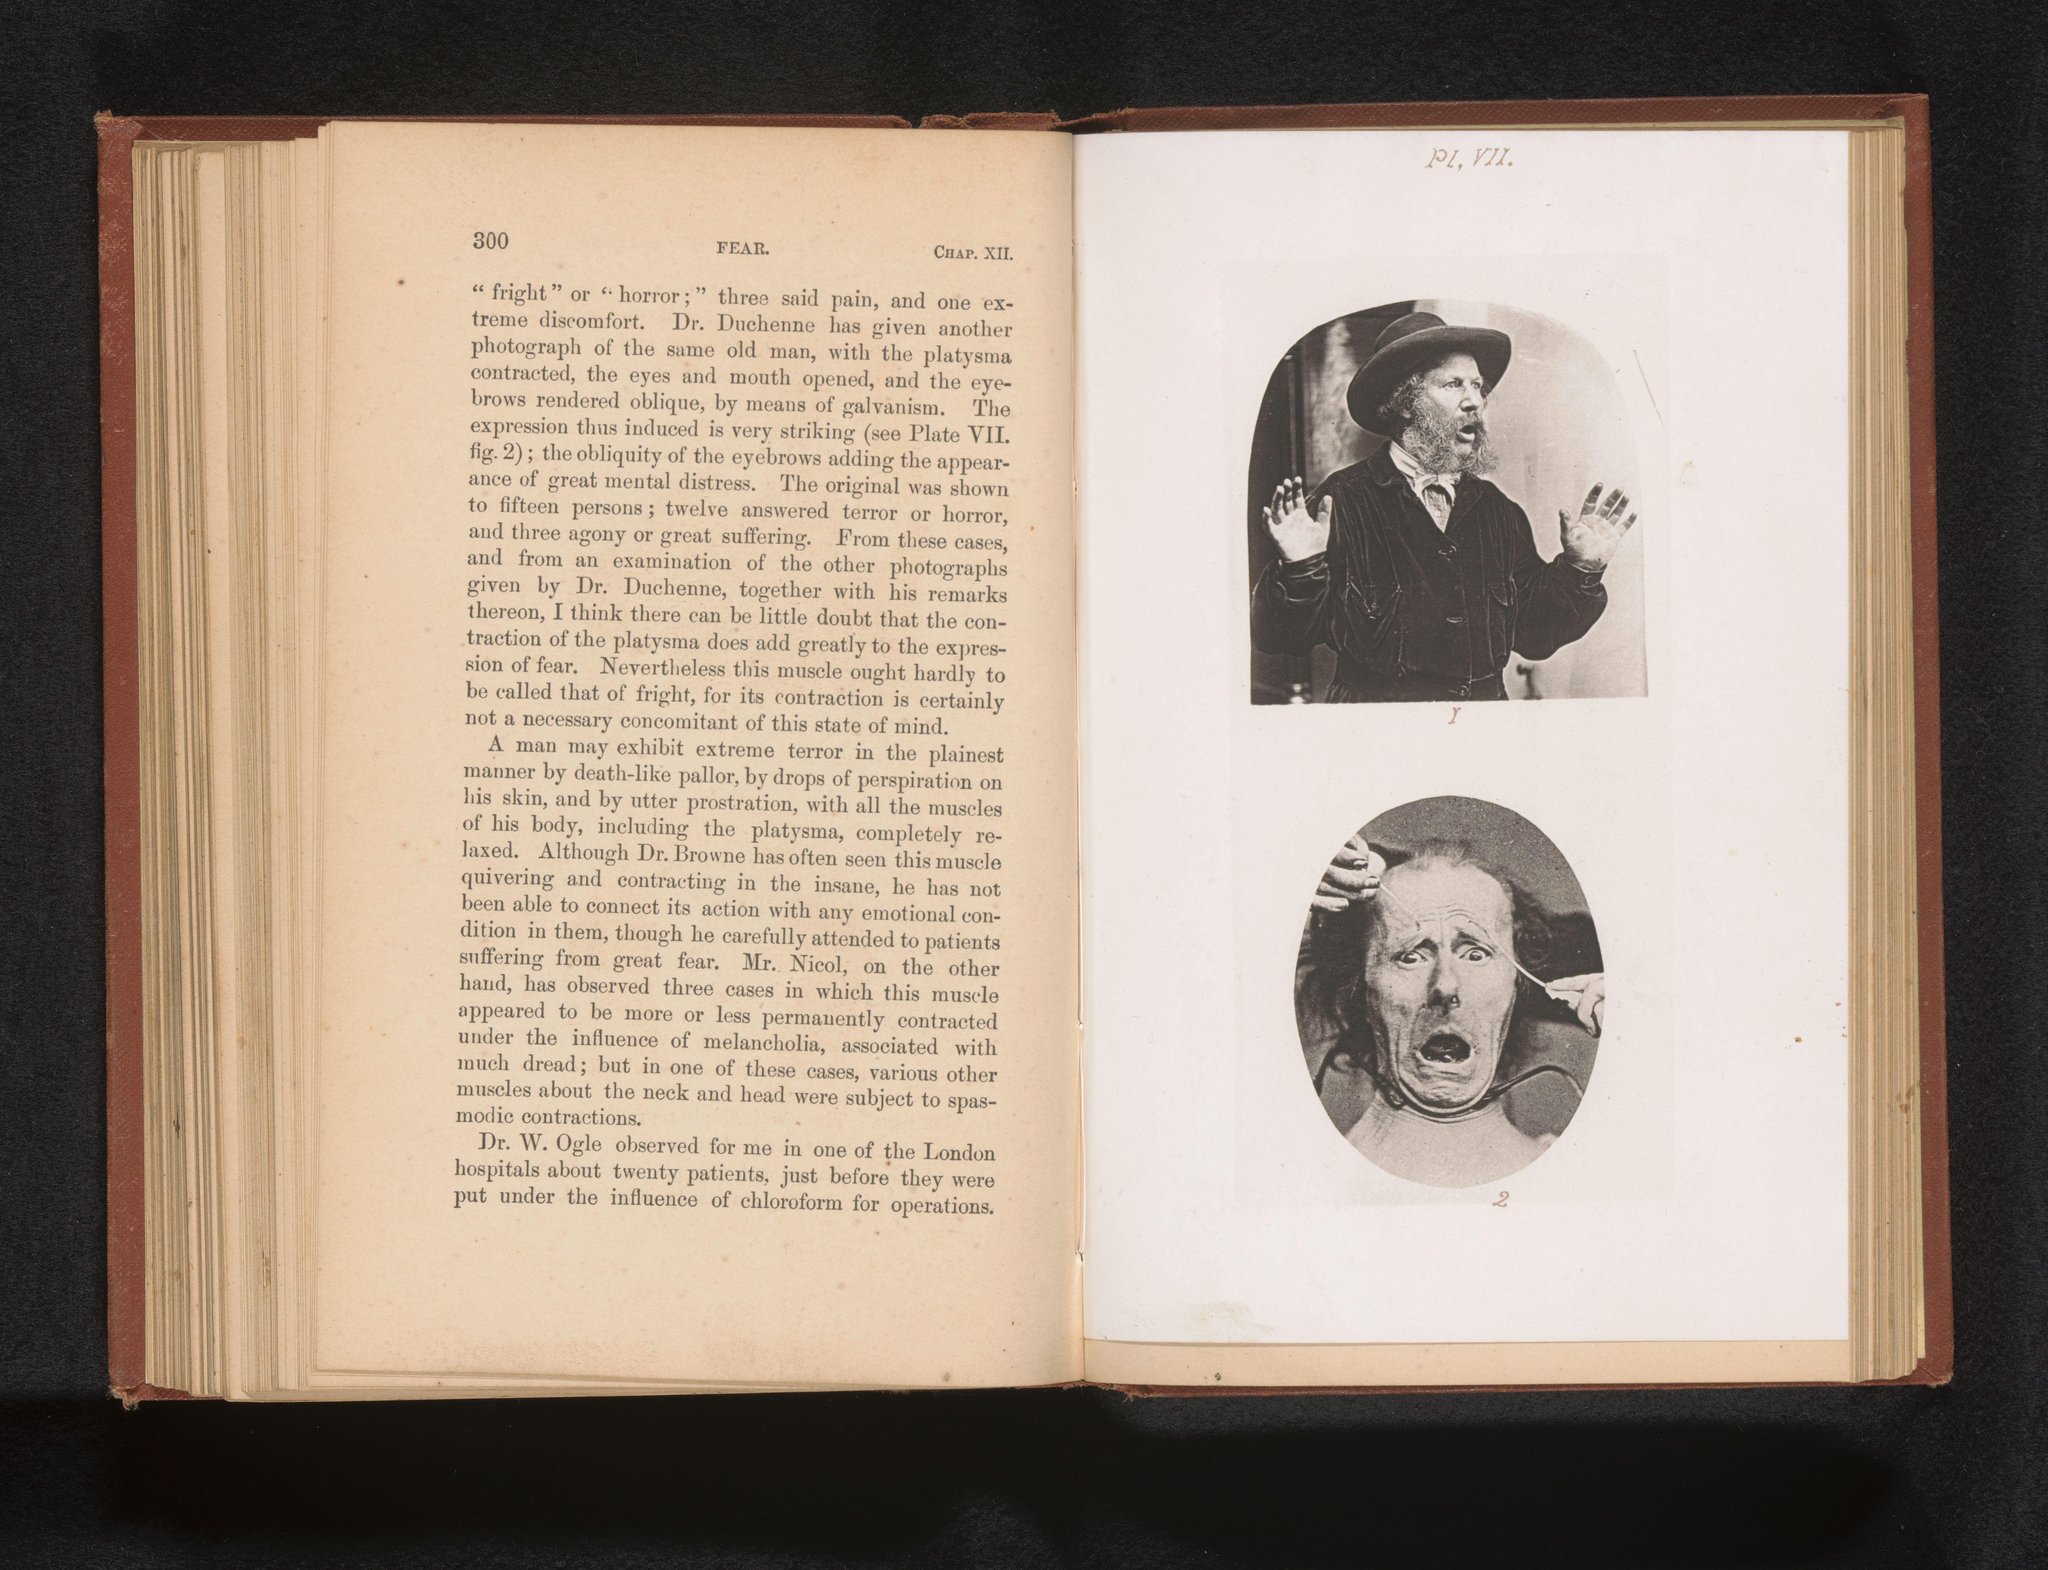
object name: page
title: Twee portretten van onbekende mannen die angst tonen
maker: Anonymous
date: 1863-1873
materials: paper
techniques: heliotype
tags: passions, emotions, affections, fear, dread; 'paura', 'timidità o timore', 'timore' (ripa)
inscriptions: number: ‘Pl. VII. 1 2’